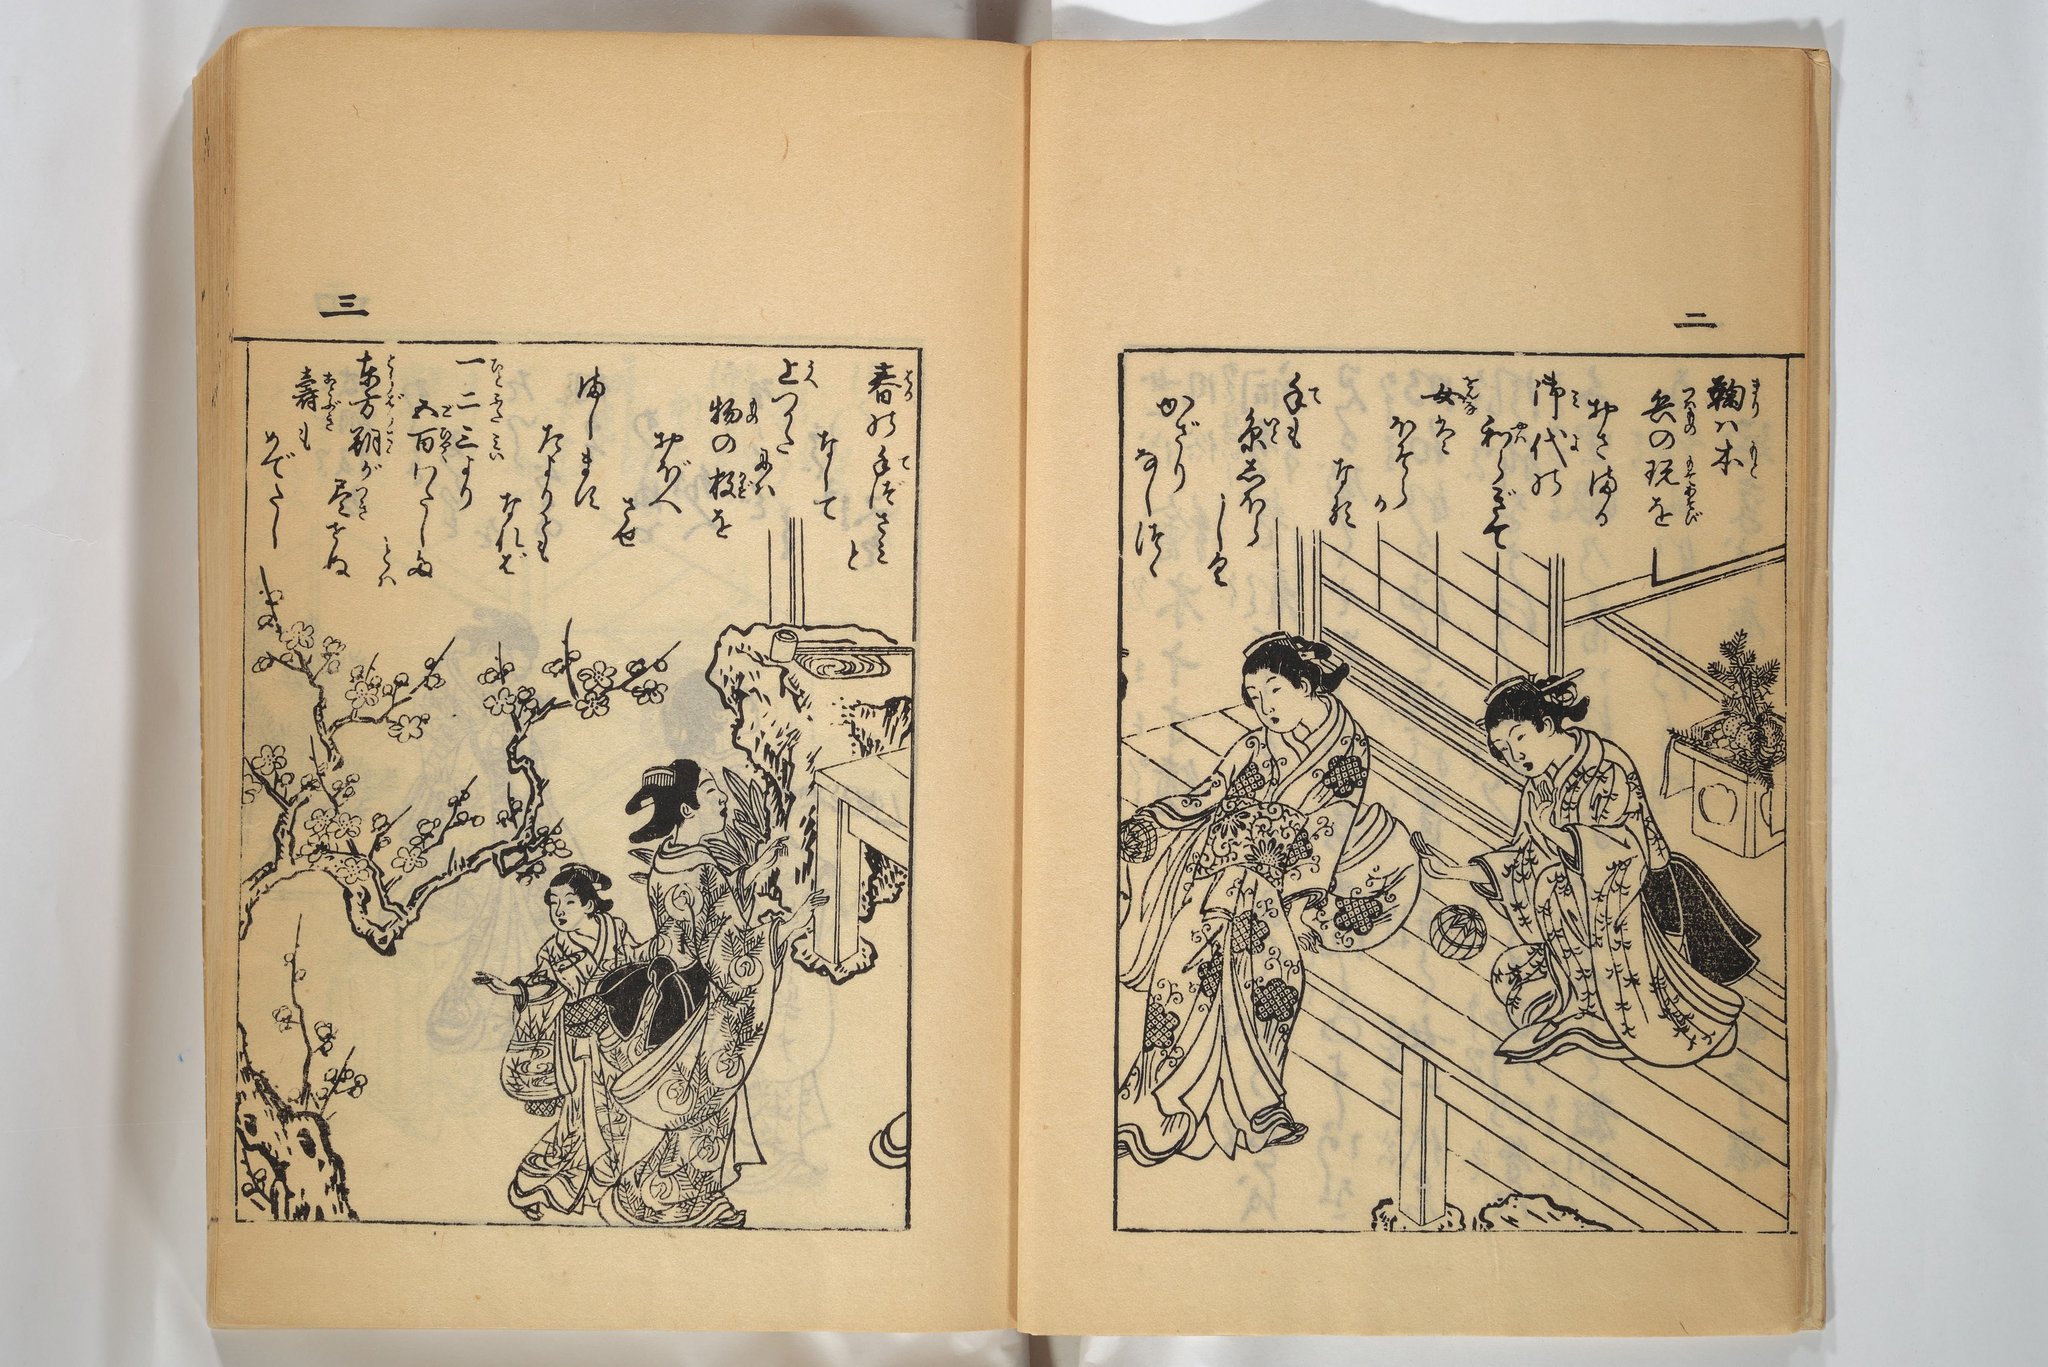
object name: illustrated book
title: Compendium on Osaka Publications (A Book of Reproductions of Osaka Prints and Text)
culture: japanese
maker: unidentified artist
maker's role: artist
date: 1901-2000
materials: ink, paper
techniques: woodblock print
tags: women